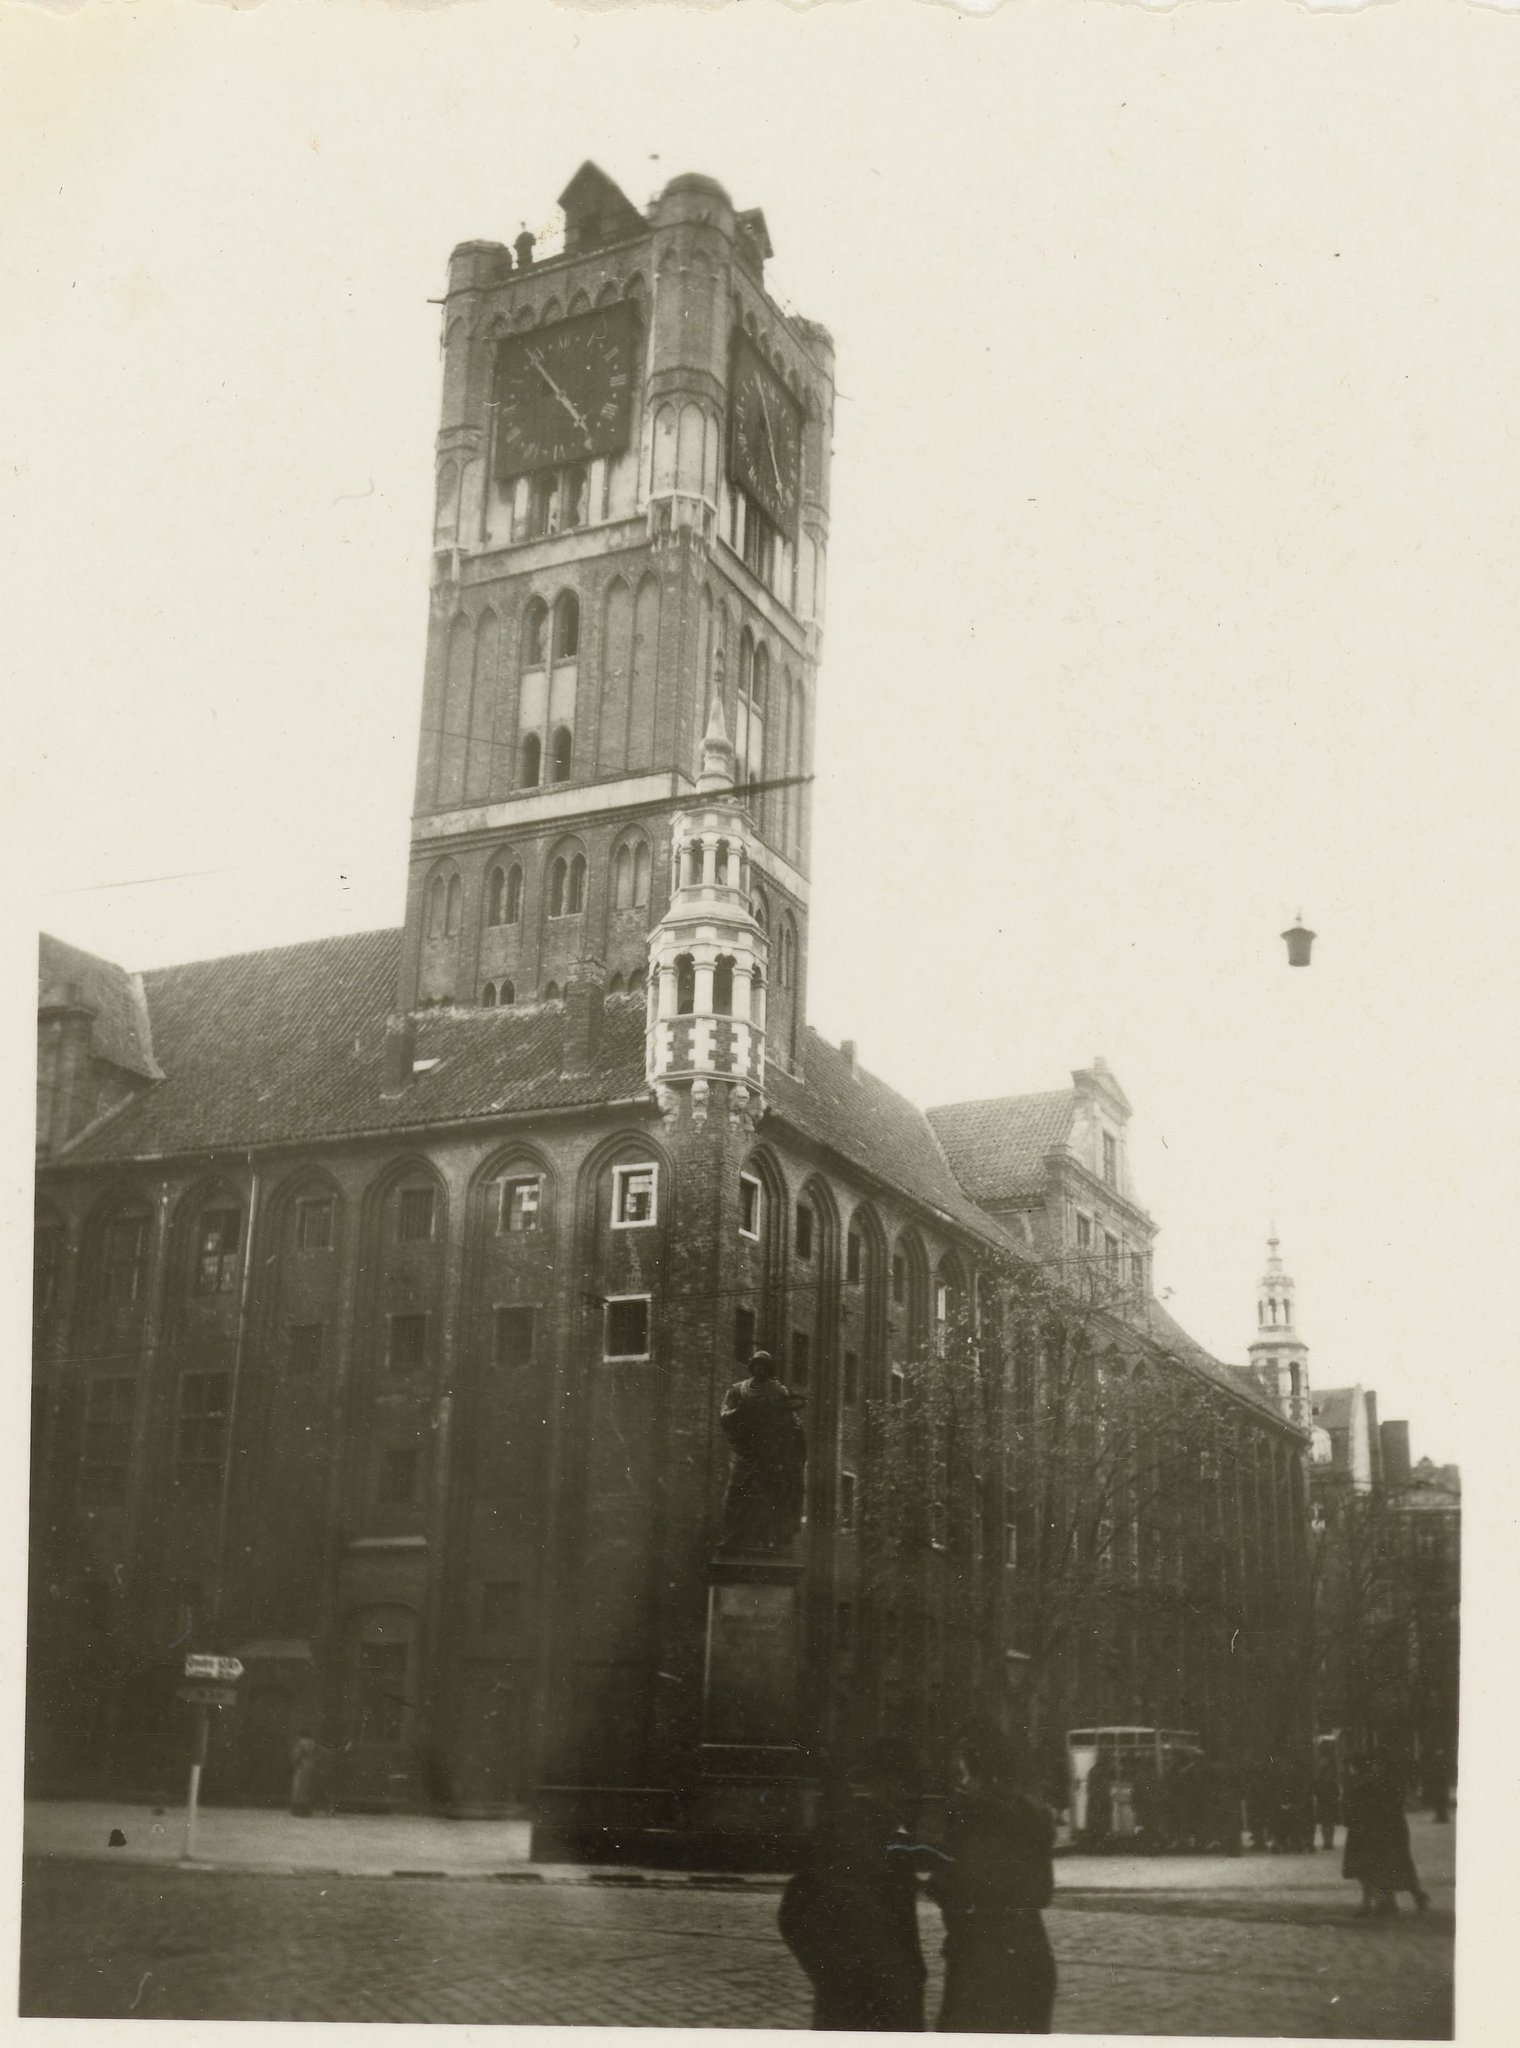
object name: photograph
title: Twee personen voor een kerk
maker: Anonymous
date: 1940-1945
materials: photographic support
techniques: gelatin silver print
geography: czechoslovakia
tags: netherlands, germany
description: Twee personen voor een kerk met een vierkante toren. Het zou in Nederland kunnen zijn. Foto behorend bij album 'Kriegserinnerungen'.